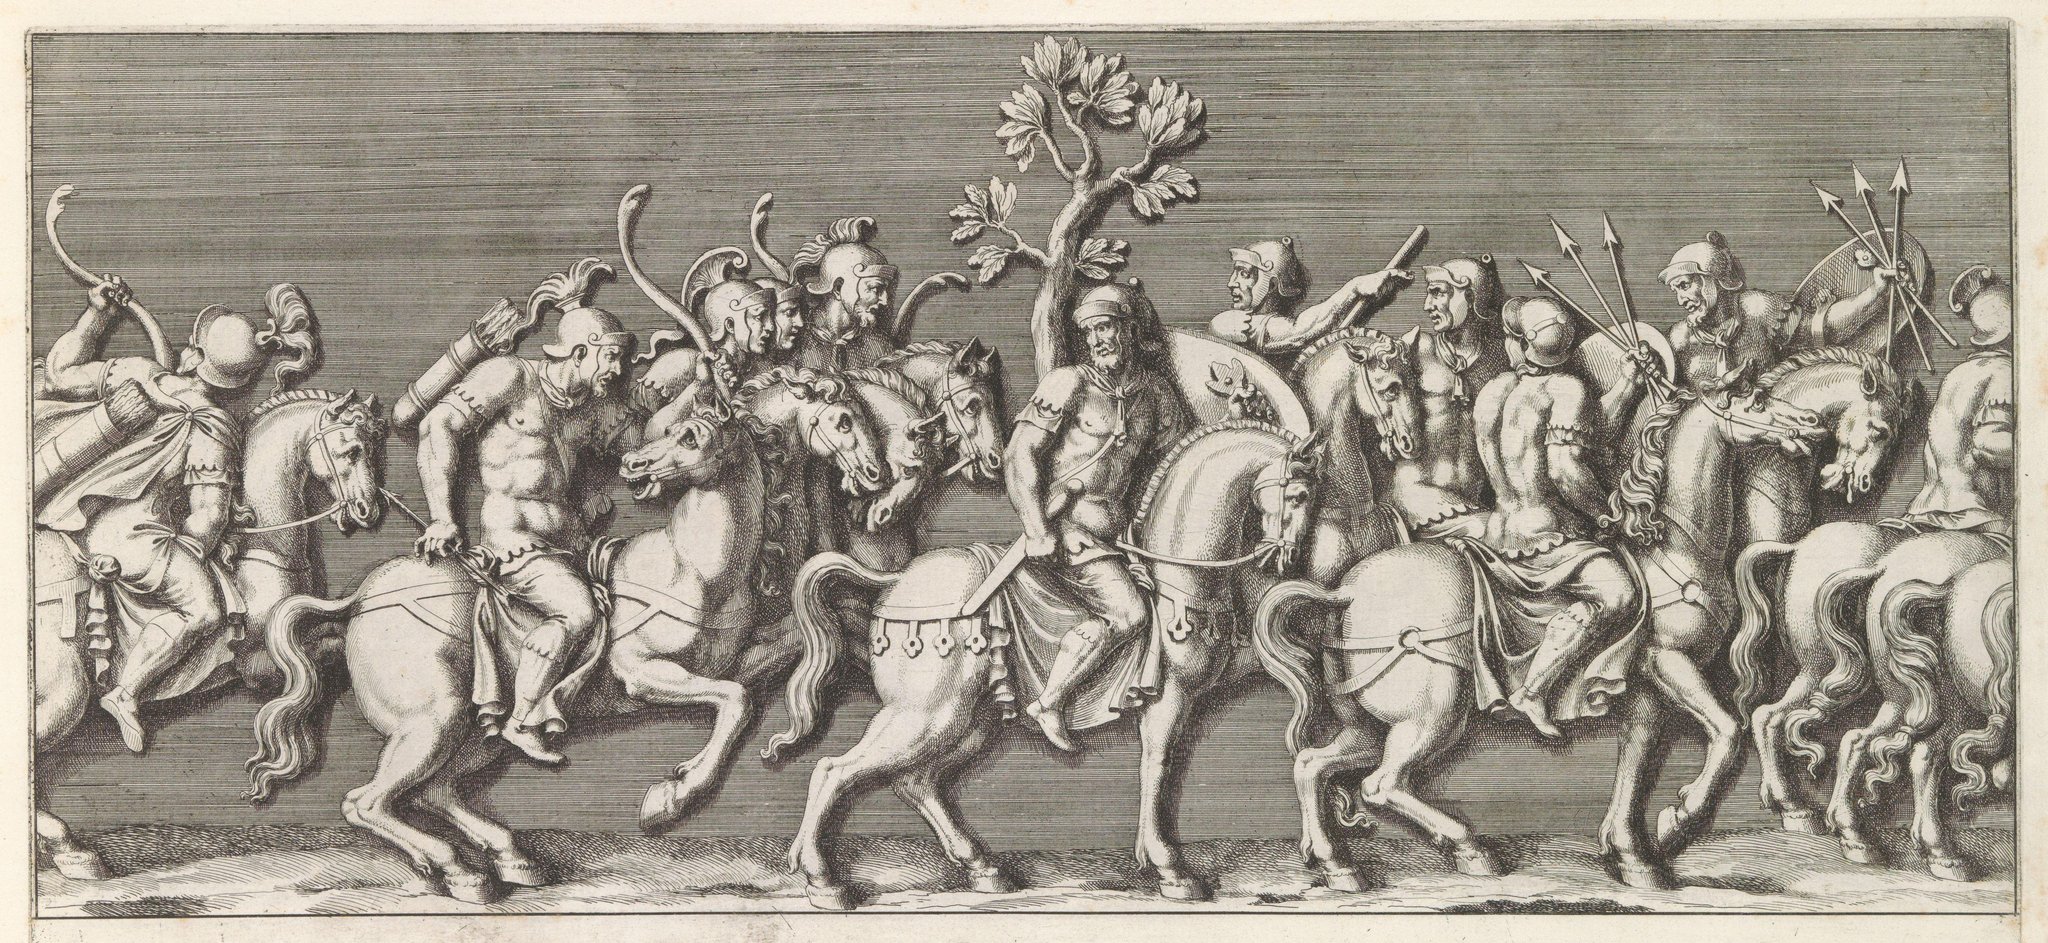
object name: album leaf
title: Stucwerk in de Sala degli Stucchi in Palazzo del Te te Mantua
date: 1680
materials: paper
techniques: etching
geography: vatican city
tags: triumphal entry and public reception, pageant, 'entrée solennelle', 'joyeuse entrée', military parade, pageant, the soldier; the soldier's life, the soldier; the soldier's life (+ cavalry, horsemen)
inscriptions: number: ‘11’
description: Prent maakt deel uit van een reeks van 25 prenten (+ titelprent) naar het stucwerk door Giulio Romano en Francesco Primaticcio in de Sala degli Stucchi in Palazzo del Te te Mantua.